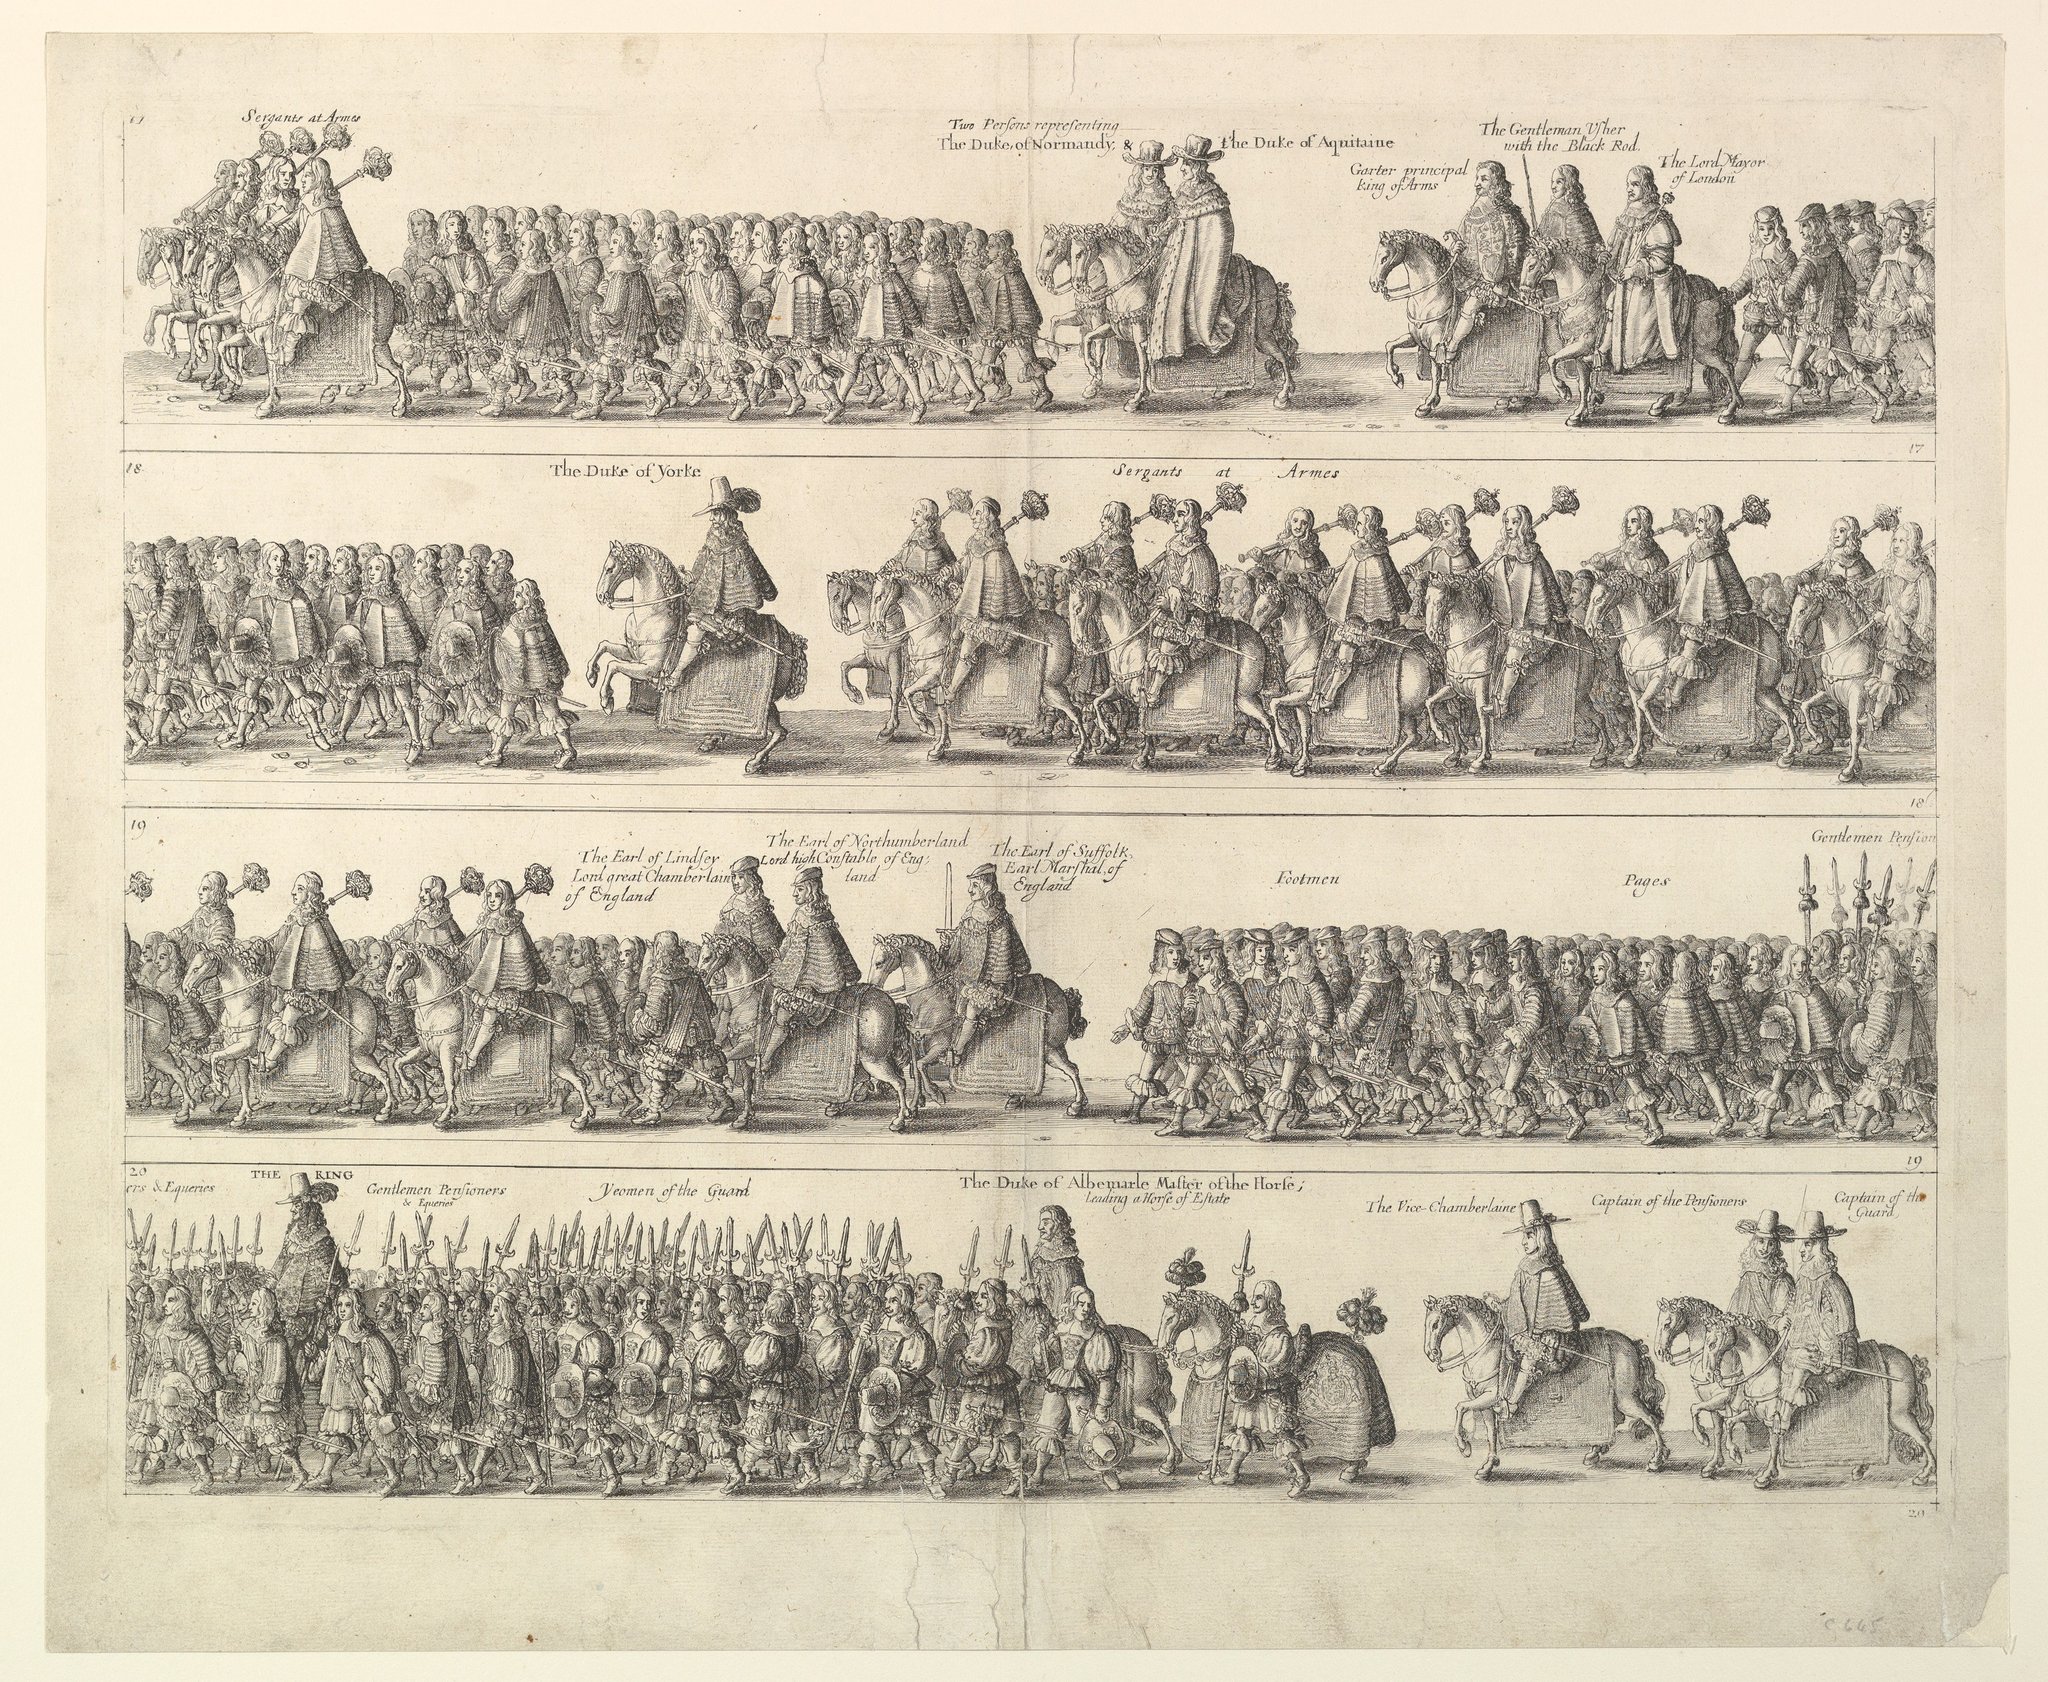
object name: print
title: Coronation Procession of Charles II Through (from John Ogilby's "The Entertainment of...Charles II," London, 1662)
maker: wenceslaus hollar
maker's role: artist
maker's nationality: bohemian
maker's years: 1607-1677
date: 1662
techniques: etching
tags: soldiers,weapons,men,horses